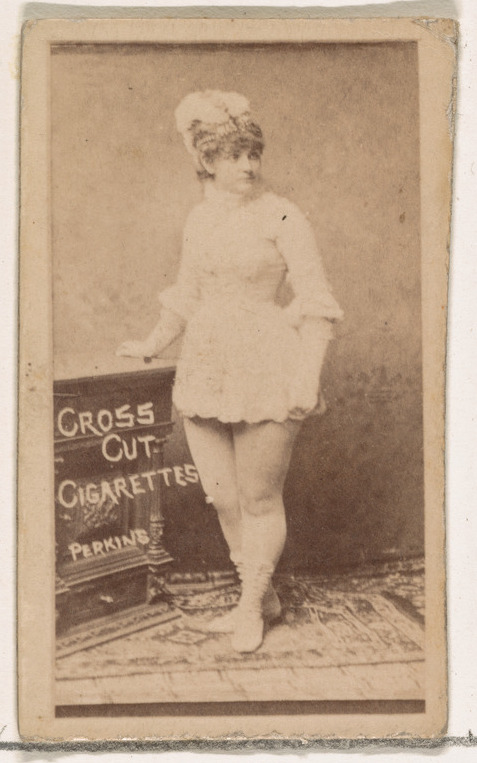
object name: print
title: Carrie Perkins, from the Actors and Actresses series (N145-1) issued by Duke Sons & Co. to promote Cross Cut Cigarettes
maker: w. duke, sons & co.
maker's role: publisher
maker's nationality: american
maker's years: 1870-1920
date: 1880-1889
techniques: albumen silver print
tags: portraits,women,actresses